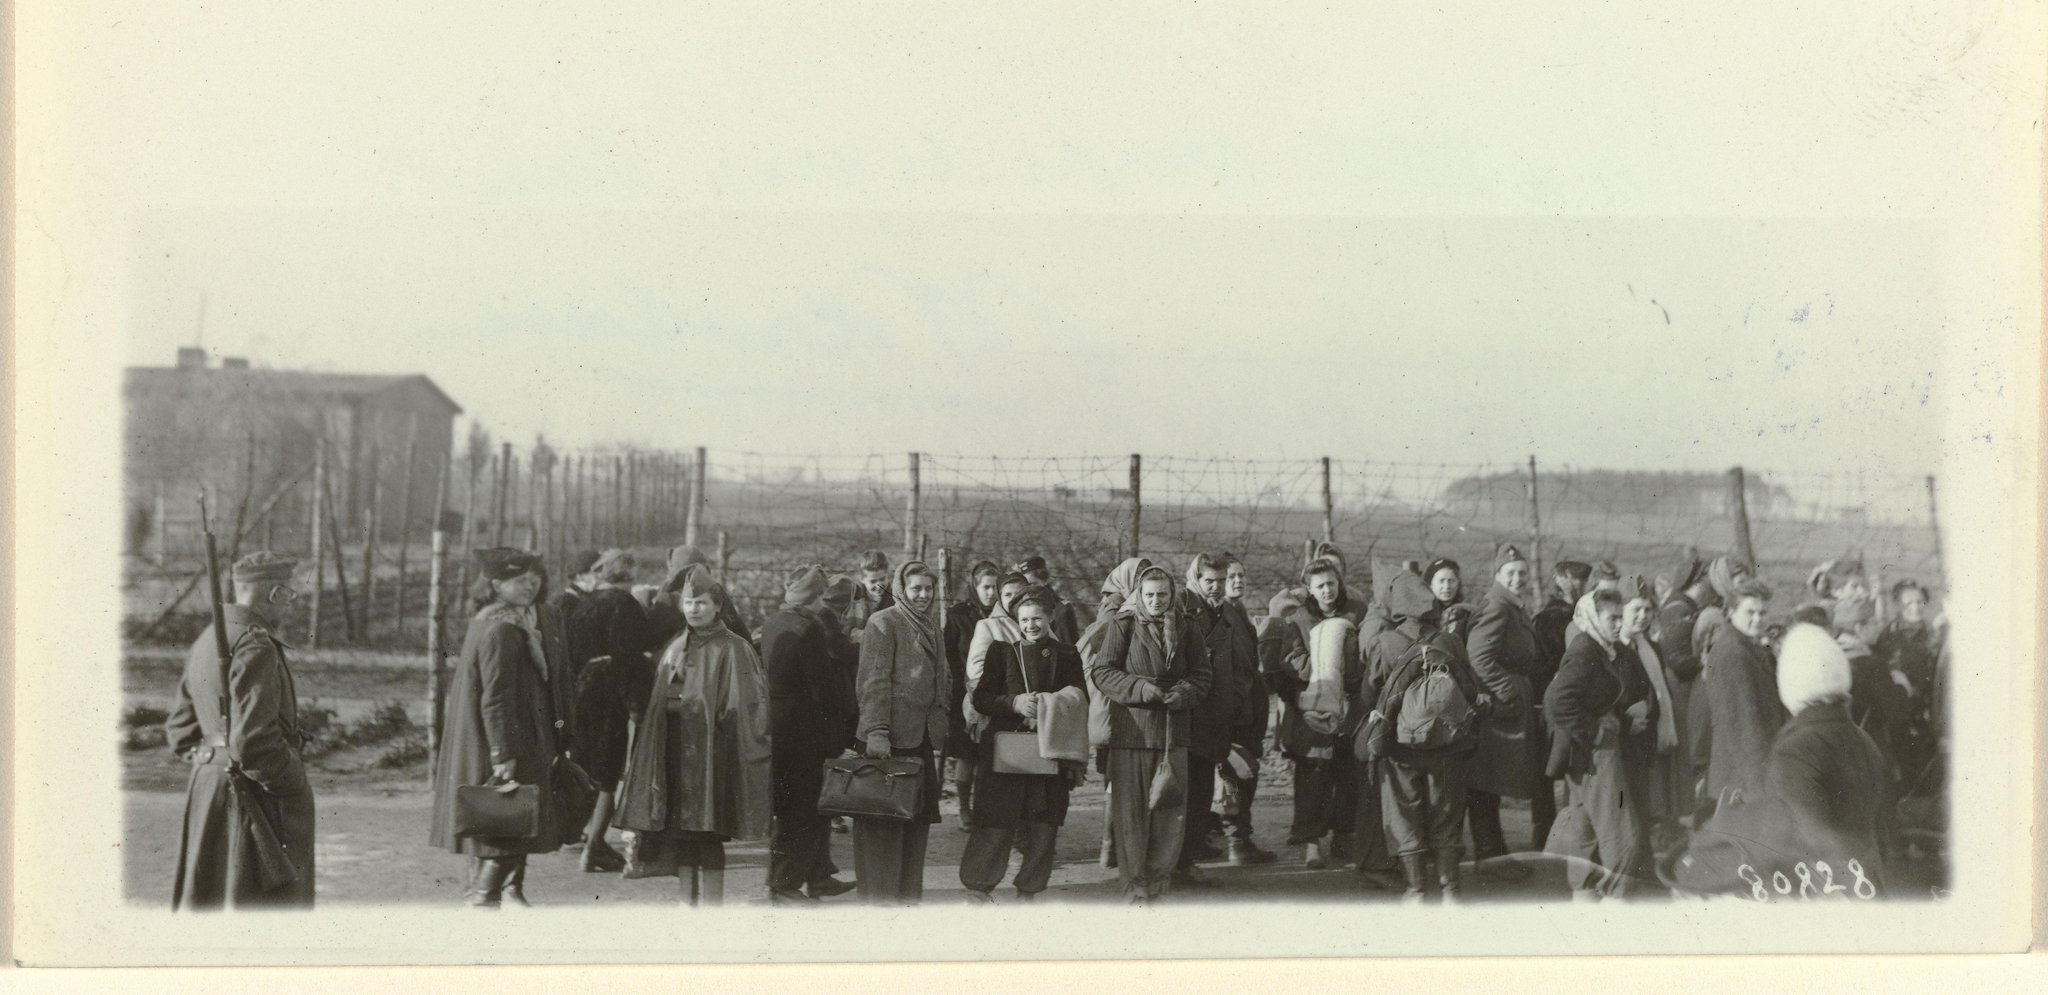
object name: photograph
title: Aankomst van Poolse vrouwelijke gevangenen in het kamp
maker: dick w.b. van maarseveen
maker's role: fotograaf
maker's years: 1905-1990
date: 1943-1945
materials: photographic support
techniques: gelatin silver print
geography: muhlberg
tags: the hague, dick w.b. van maarseveen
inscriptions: workshop stamp: ‘Foto D. van Maarseveen Bezuidenhoutseweg 78 Telefoon 83 80 22 Den Haag’, inscription: ‘laatste verdedigers van Warschau’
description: Aankomst in het kamp van een groep vrouwelijke verdedigers van Warschau tijdens de grote opstand eind 1944. Onderdeel van een groep foto's gemaakt door Dick van Maarseveen in het Duitse krijgsgevangenenkamp Stalag IV B in Mühlberg in de periode 1943-1945.